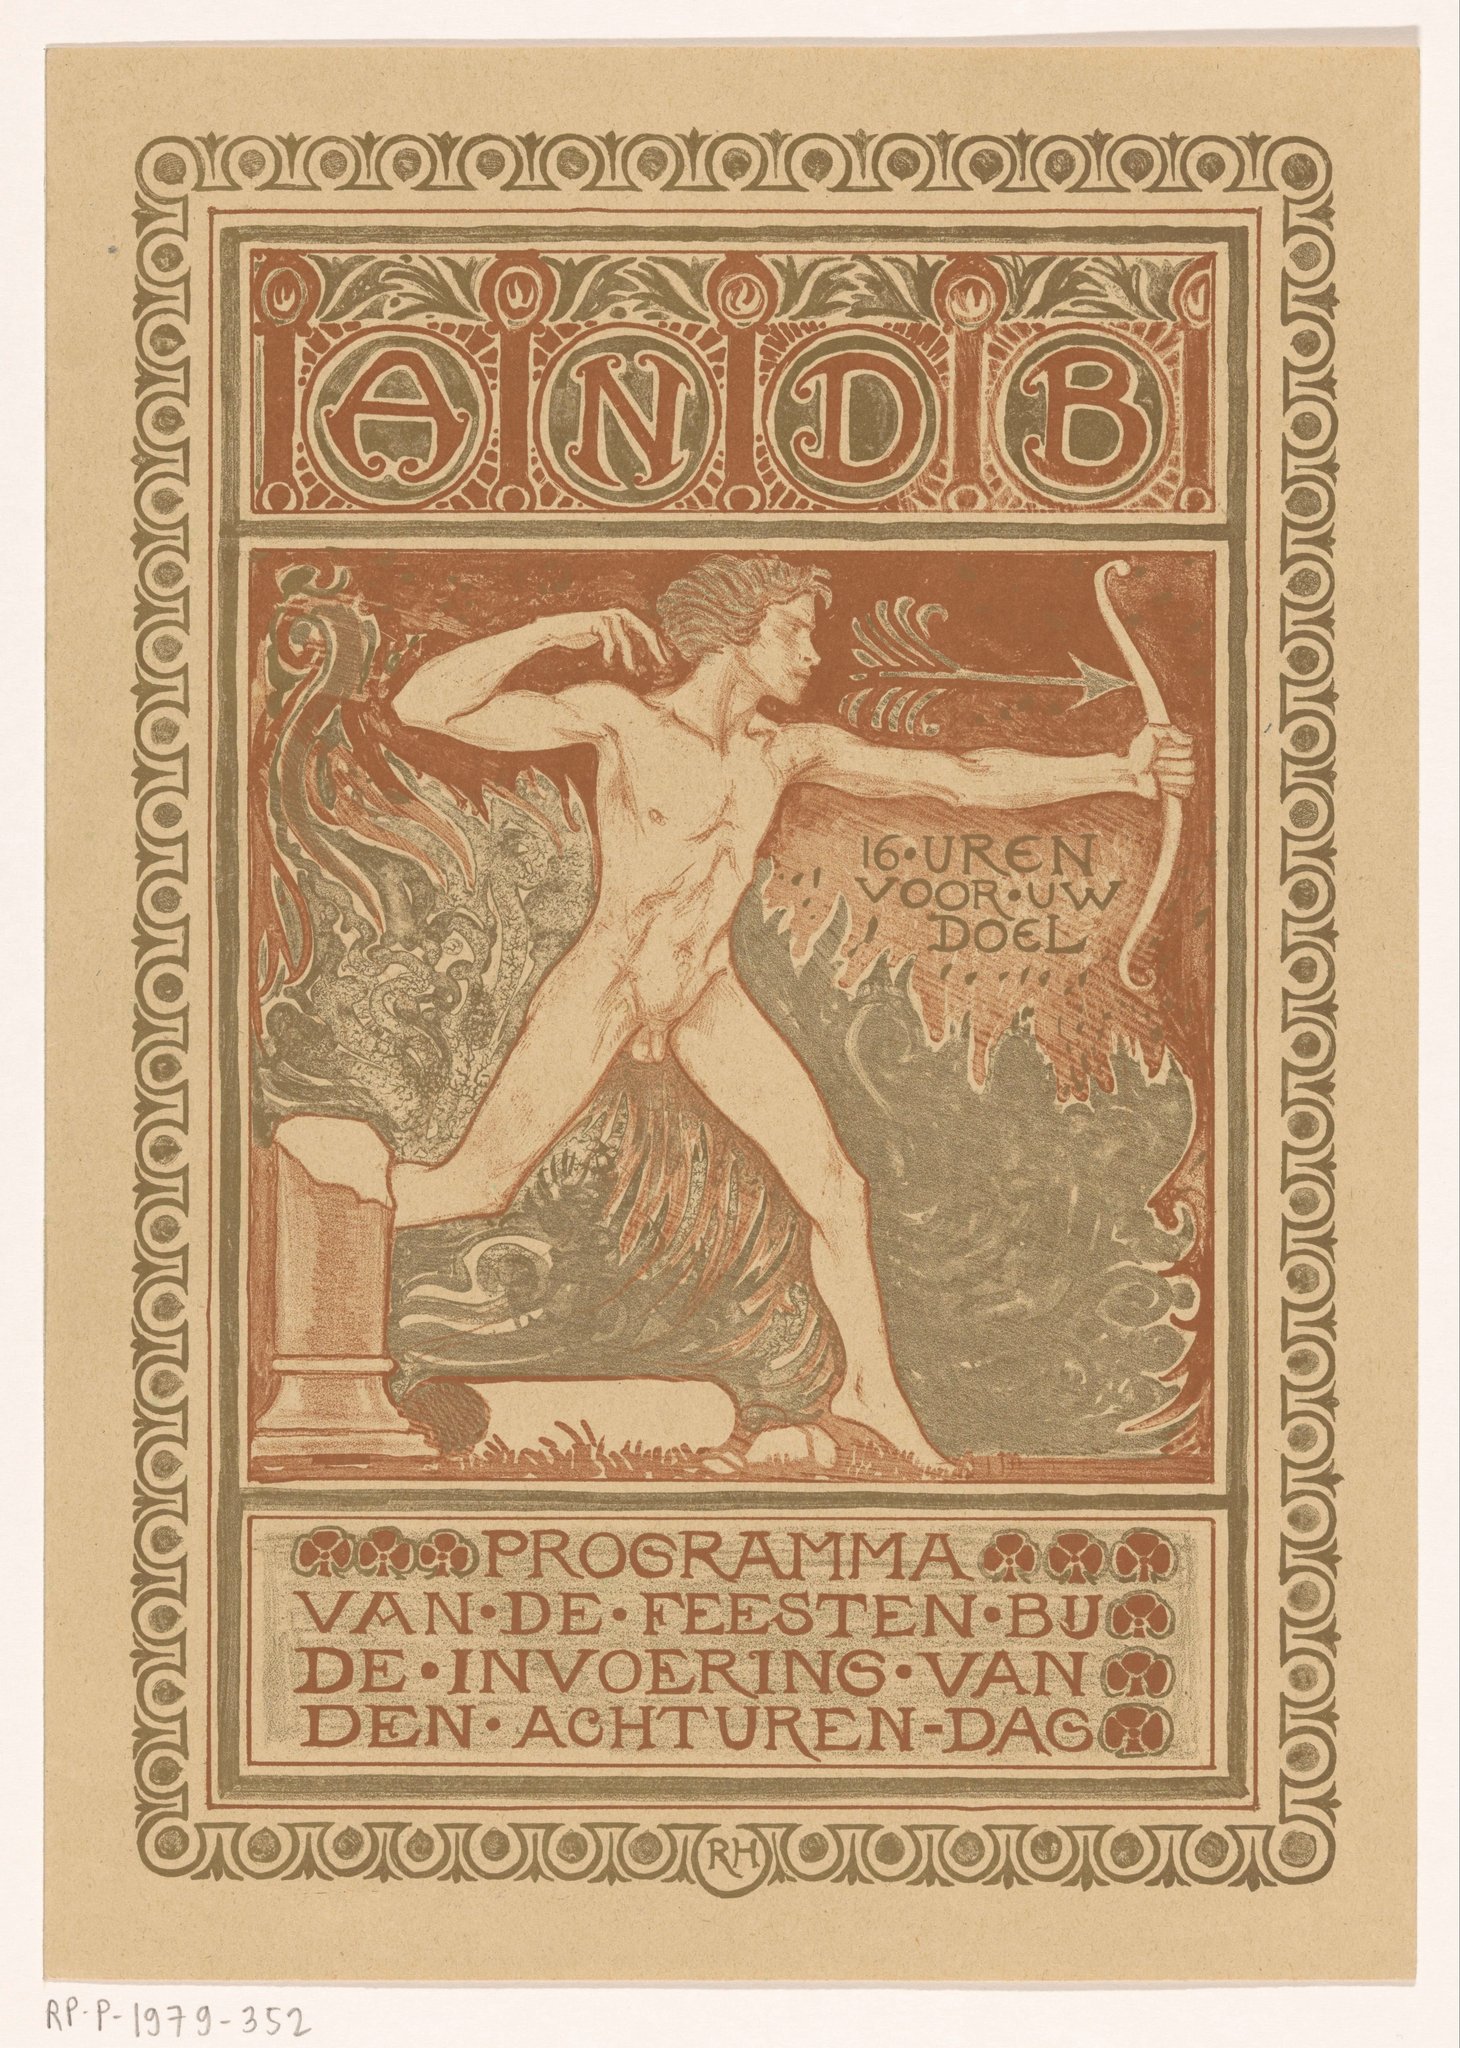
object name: print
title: Omslagontwerp voor: Feestprogramma van de Algemene Nederlandse Diamantbewerkersbond bij de invoering van de achturendag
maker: richard nicolaüs roland holst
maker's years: 1868-1938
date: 1911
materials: paper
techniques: lithograph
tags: archer's weapons: bow and arrow, column, pillar ~ architecture, man (showing himself) undressed, quasi-nude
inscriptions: collector's mark: Lugt 2228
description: Een rechthoekig kader met daarin een naakte man die met een boog een pijl afschiet. Onder zijn gestrekte arm de tekst '16 uren voor uw doel'. Bij zijn benen een gebroken zuil.